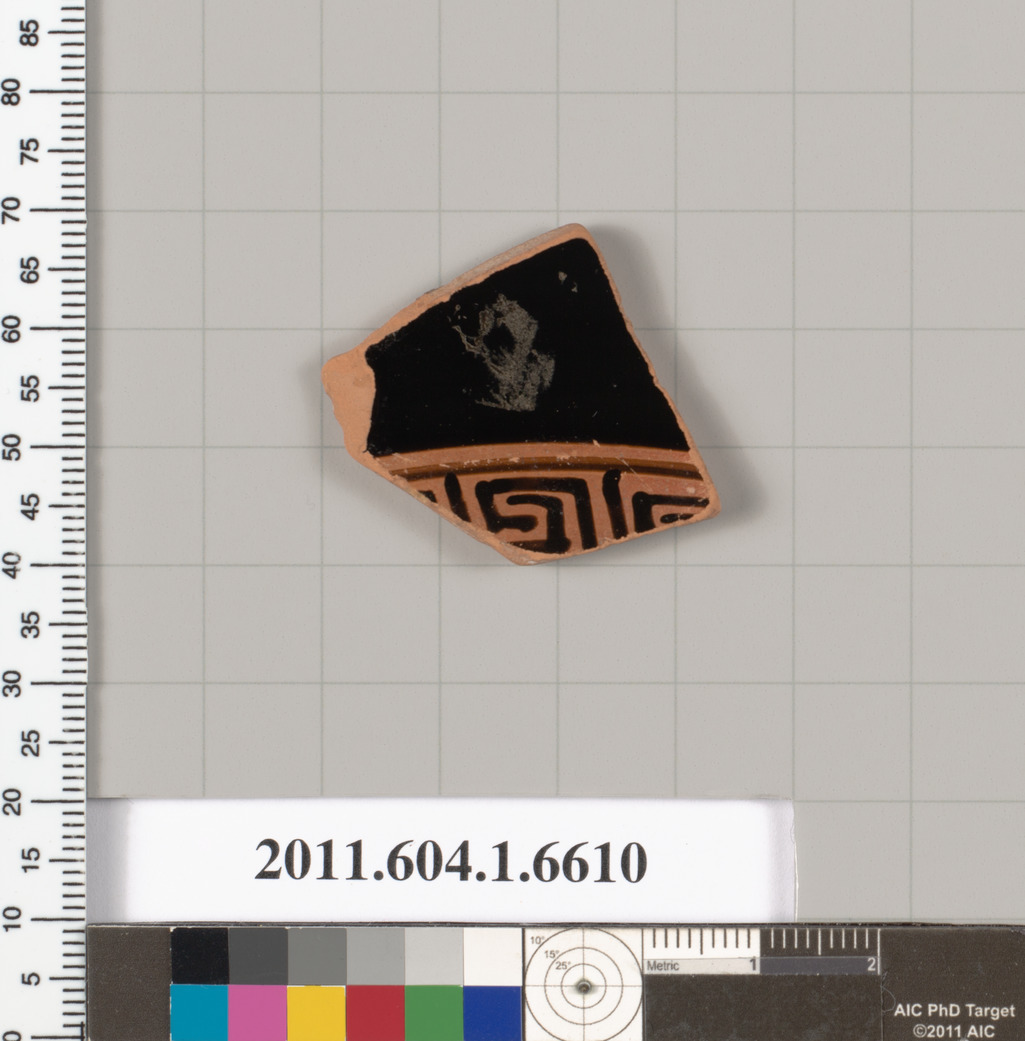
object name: kylix fragment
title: Terracotta fragment of a kylix (drinking cup)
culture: greek, attic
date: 490-480 BCE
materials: terracotta